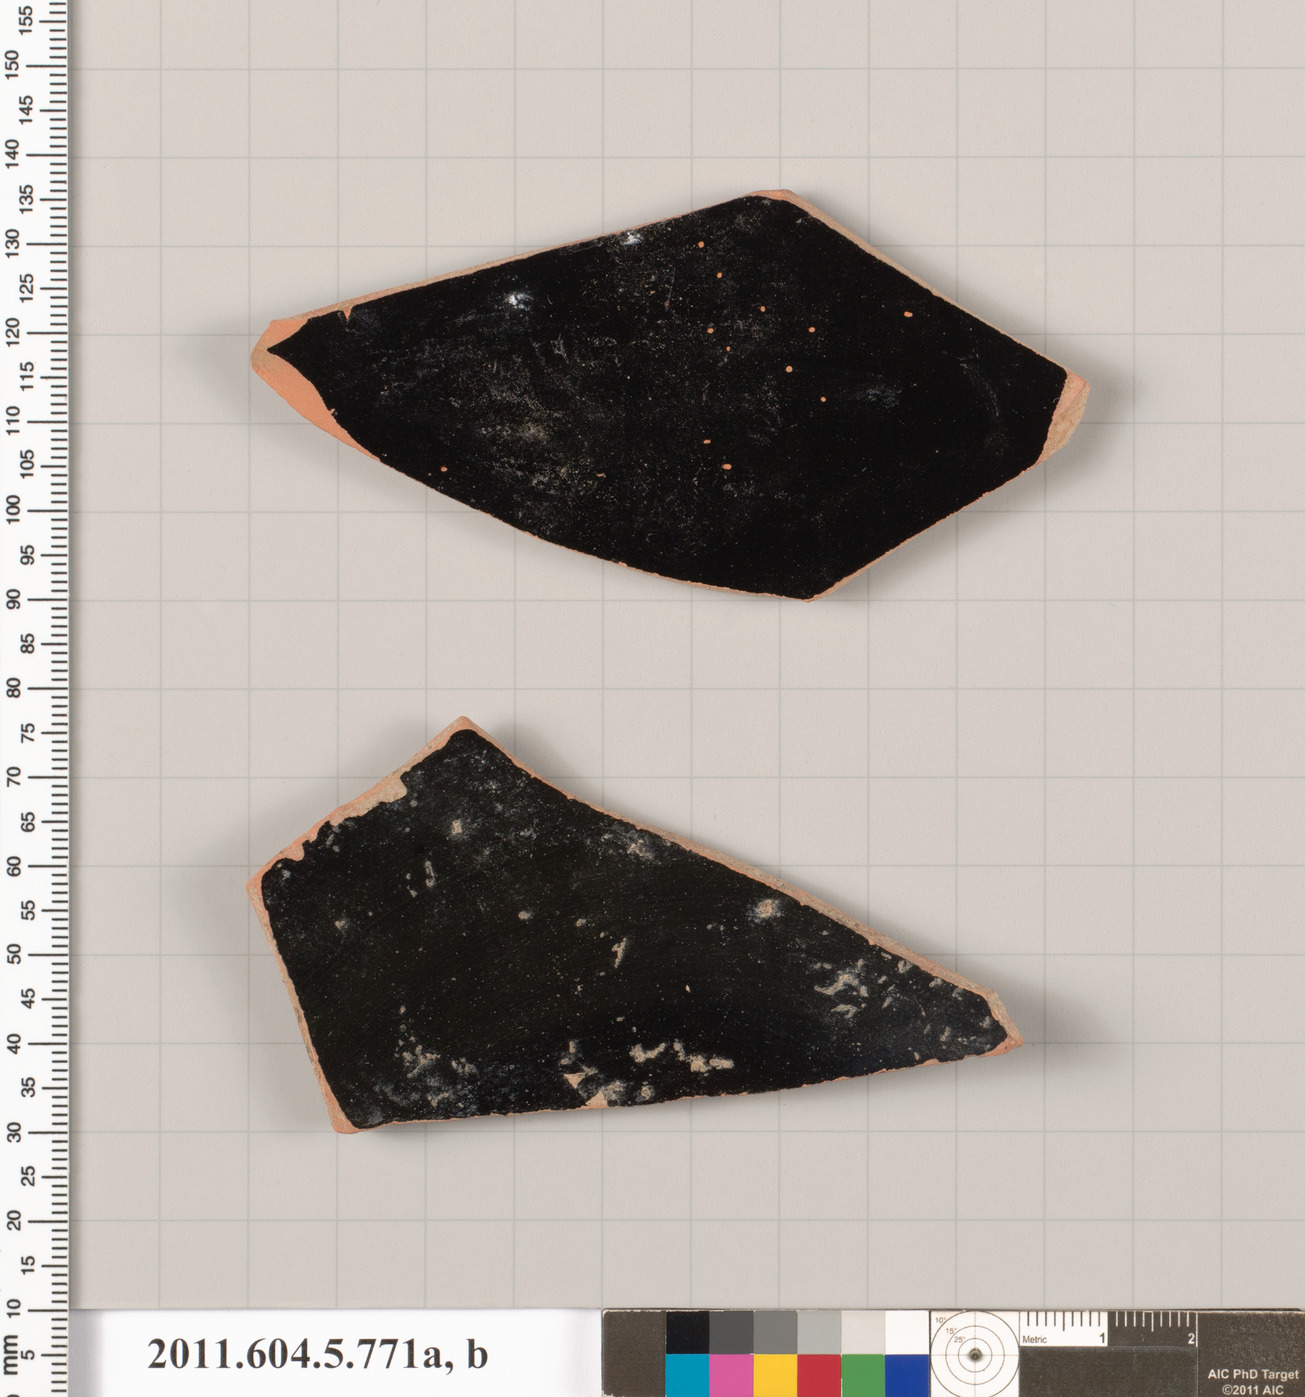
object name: kylix fragment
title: Terracotta fragments of kylikes (drinking cups)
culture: greek, attic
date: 600-401 BCE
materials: terracotta